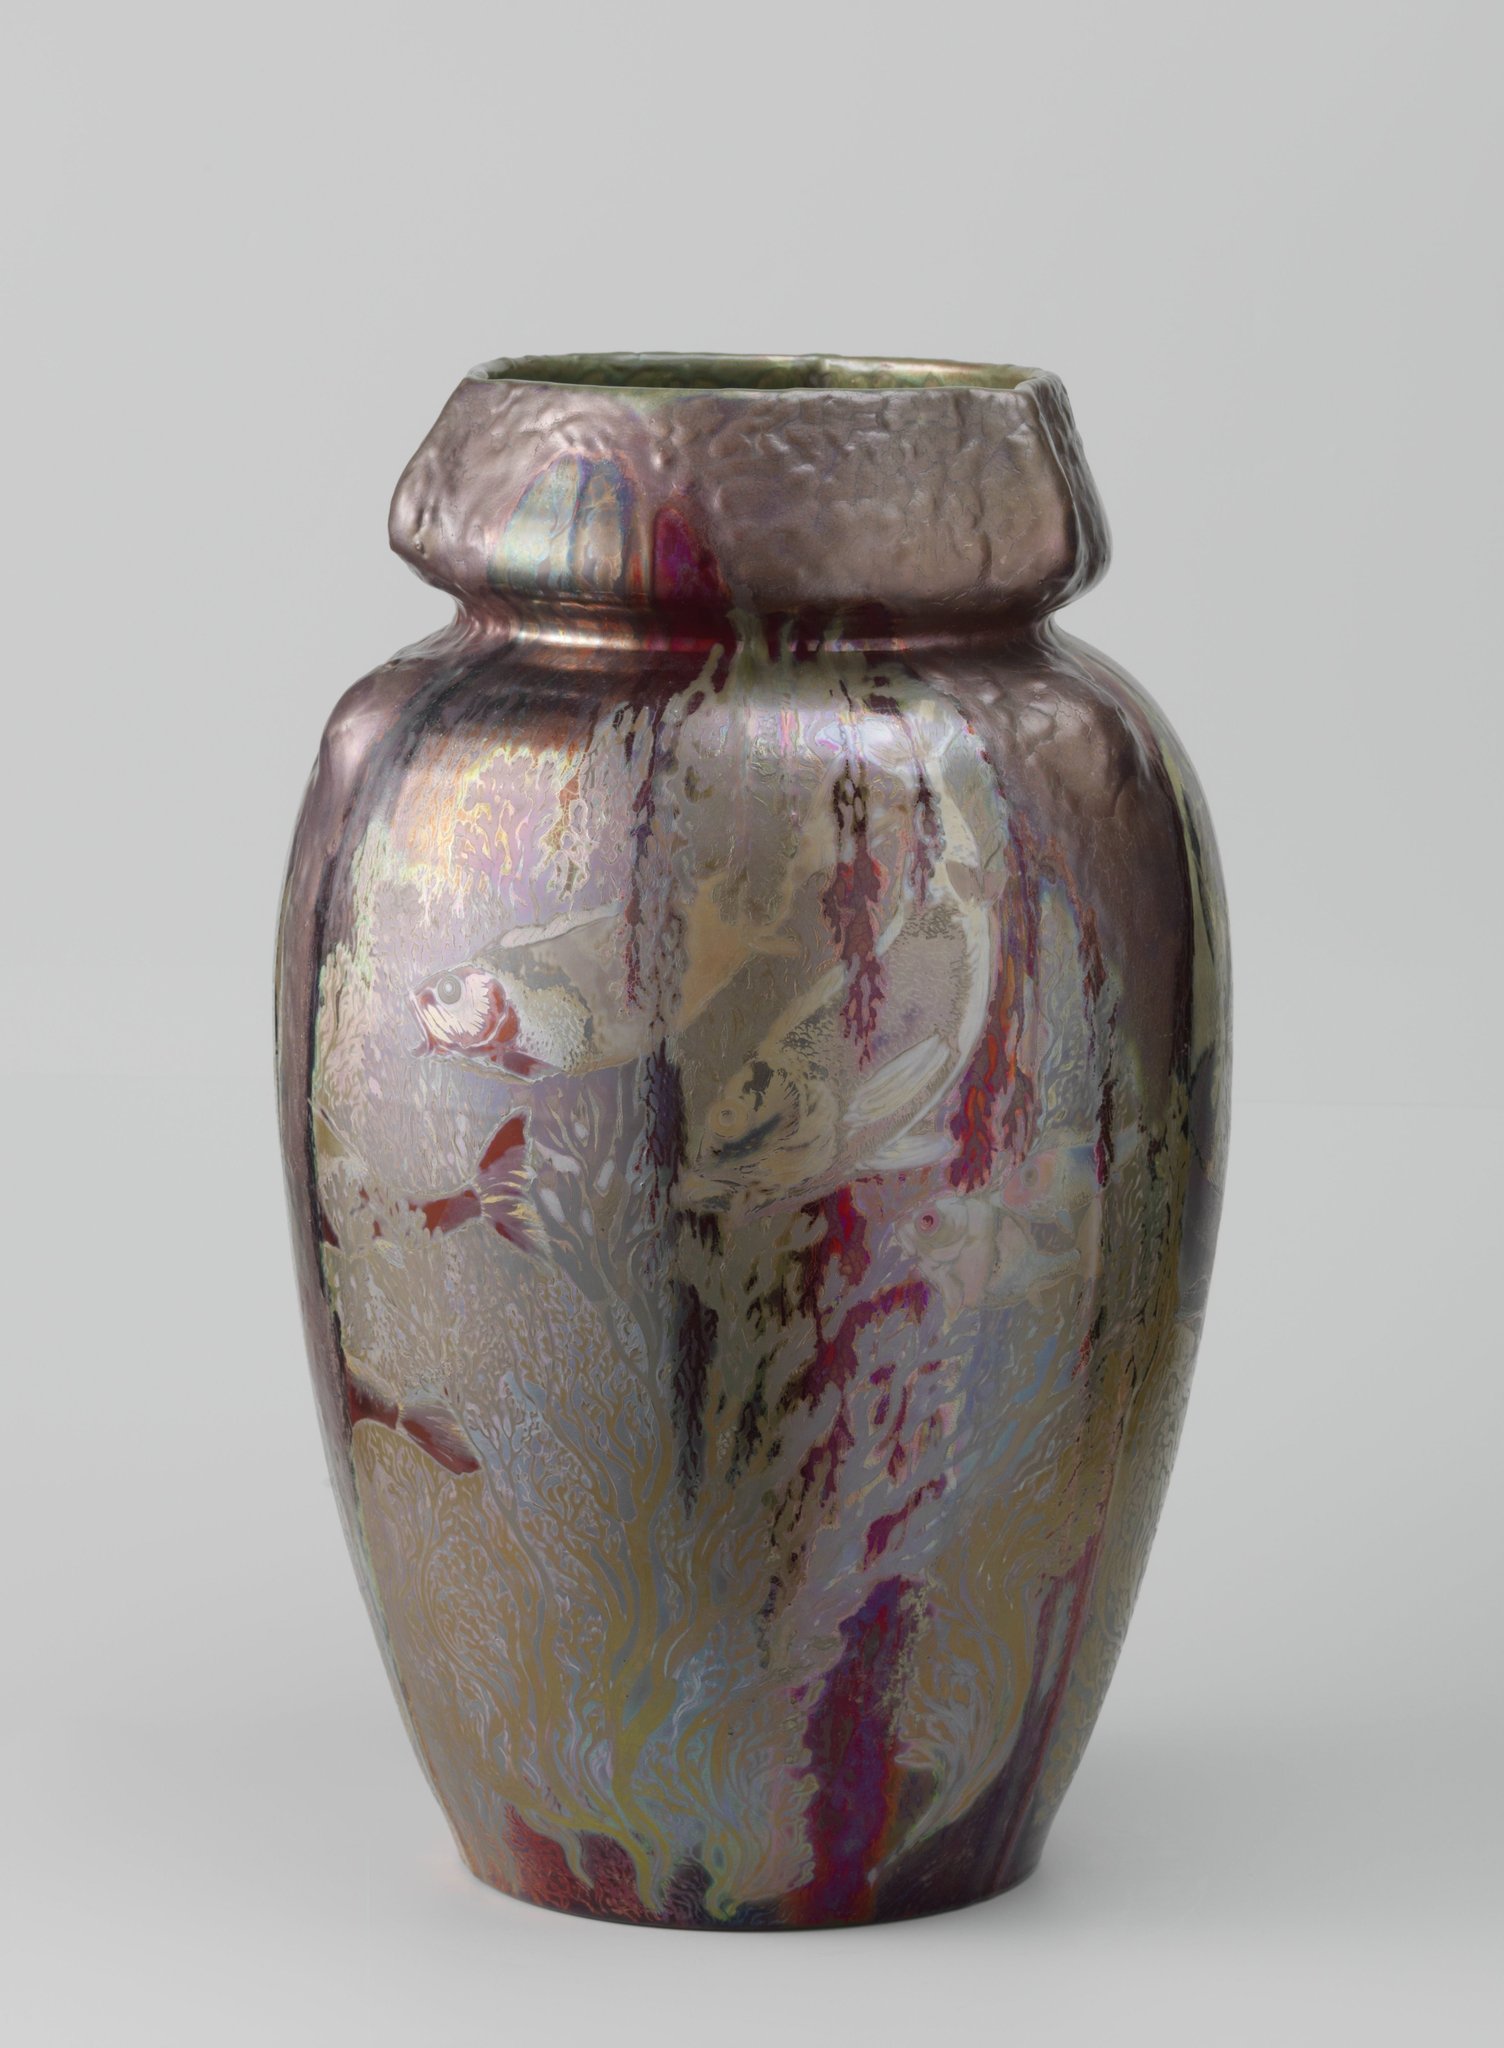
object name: vase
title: Vase with a Fish Pattern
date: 1900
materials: stoneware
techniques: painted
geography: golfe-juan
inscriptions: signature: ‘M. Alexandre’, mark: ‘Clement Massier Golfe-Juan A.M. met luster, ingestempeld Clement Golfe Juan AM en ingegrift 2.’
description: Vaas van steengoed, beschilderd onder andere in zilver- en goudluster met vissen in wier, op rode fond. Boven de voetrand gesigneerd M. Alexandre. Gemerkt met: Clement Massier Golfe-Juan A.M. met luster, ingestempeld Clement Golfe Juan AM en ingegrift 2.